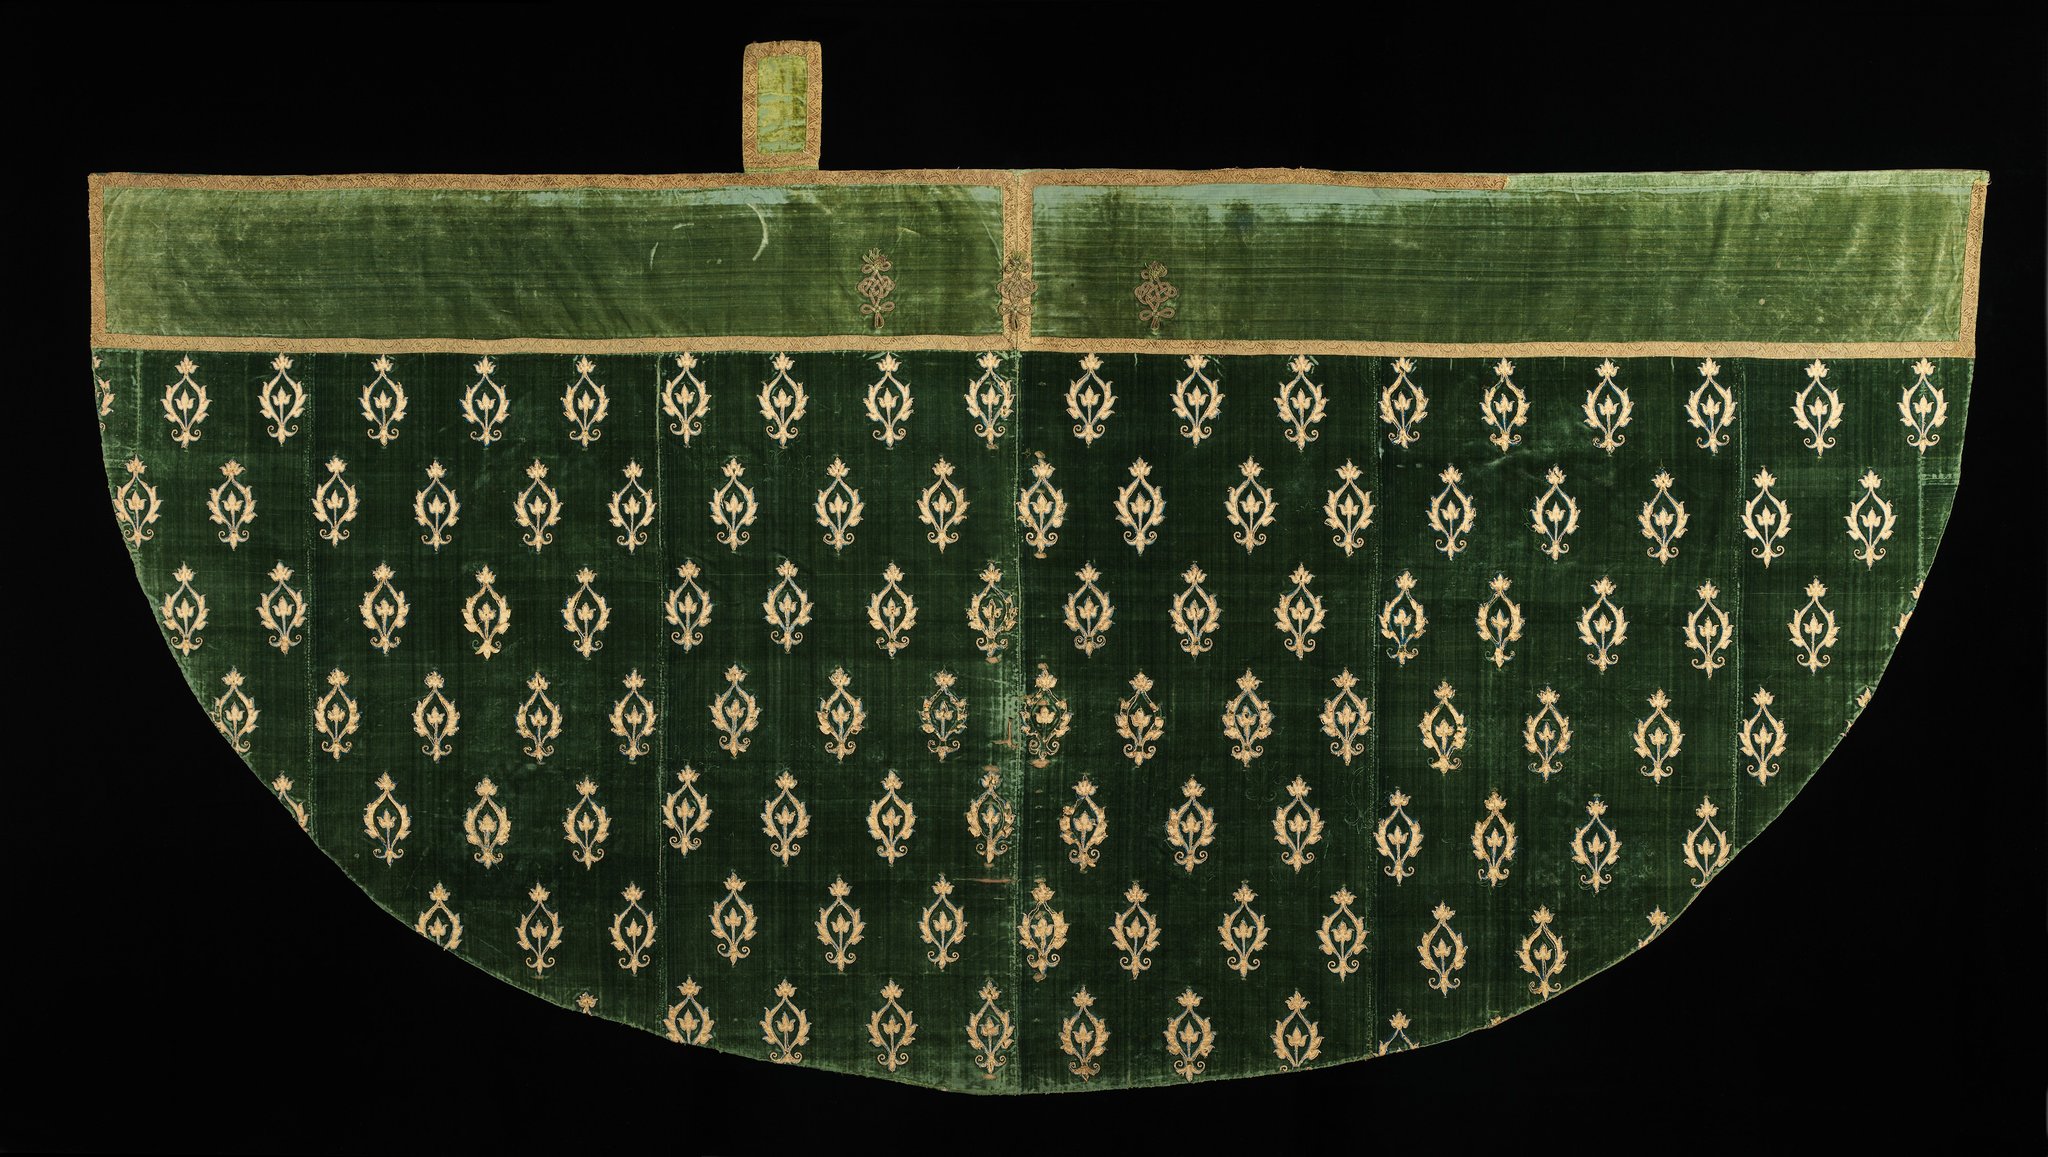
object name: cope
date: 1651-1675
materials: metal, silk